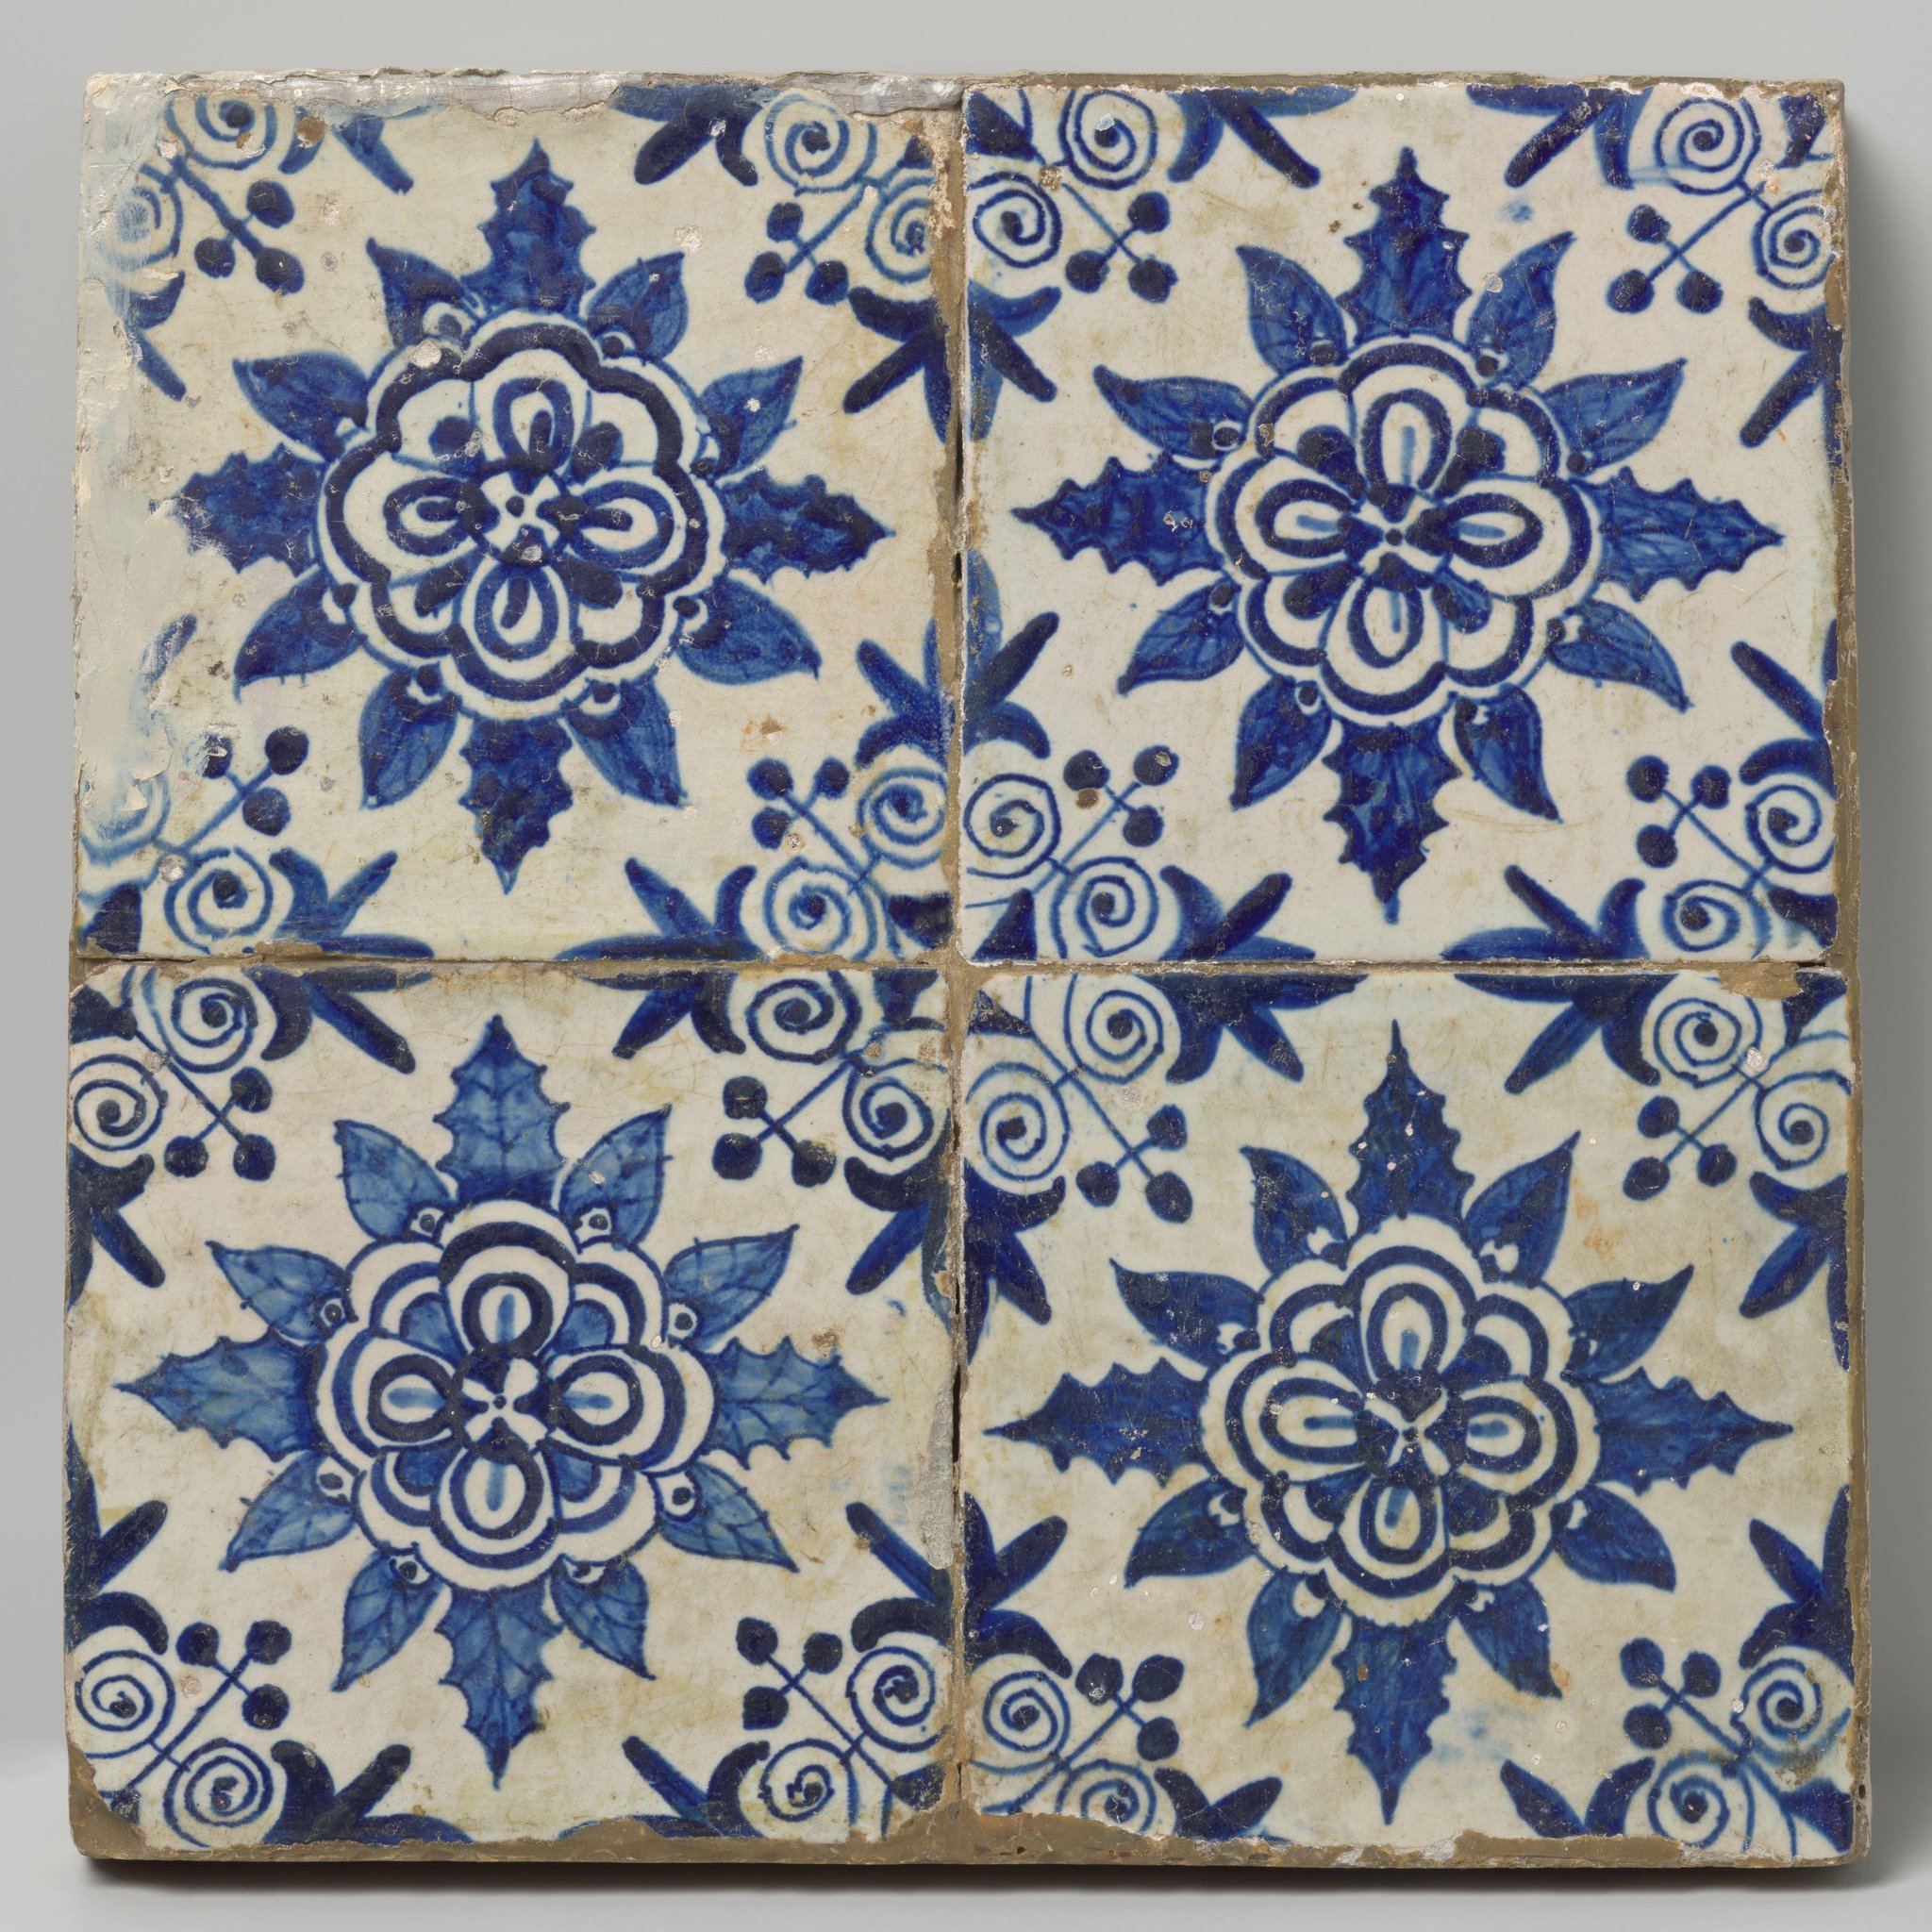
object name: tegelveld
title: Veld van vier tegels met rozetten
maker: Anonymous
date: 1620-1640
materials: earthenware, glaze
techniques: maiolica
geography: haarlem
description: Veld van vier tegels (2 x 2) elk met een blauw geschilderde rozet versierd met bladeren. In de hoeken, een driestip.